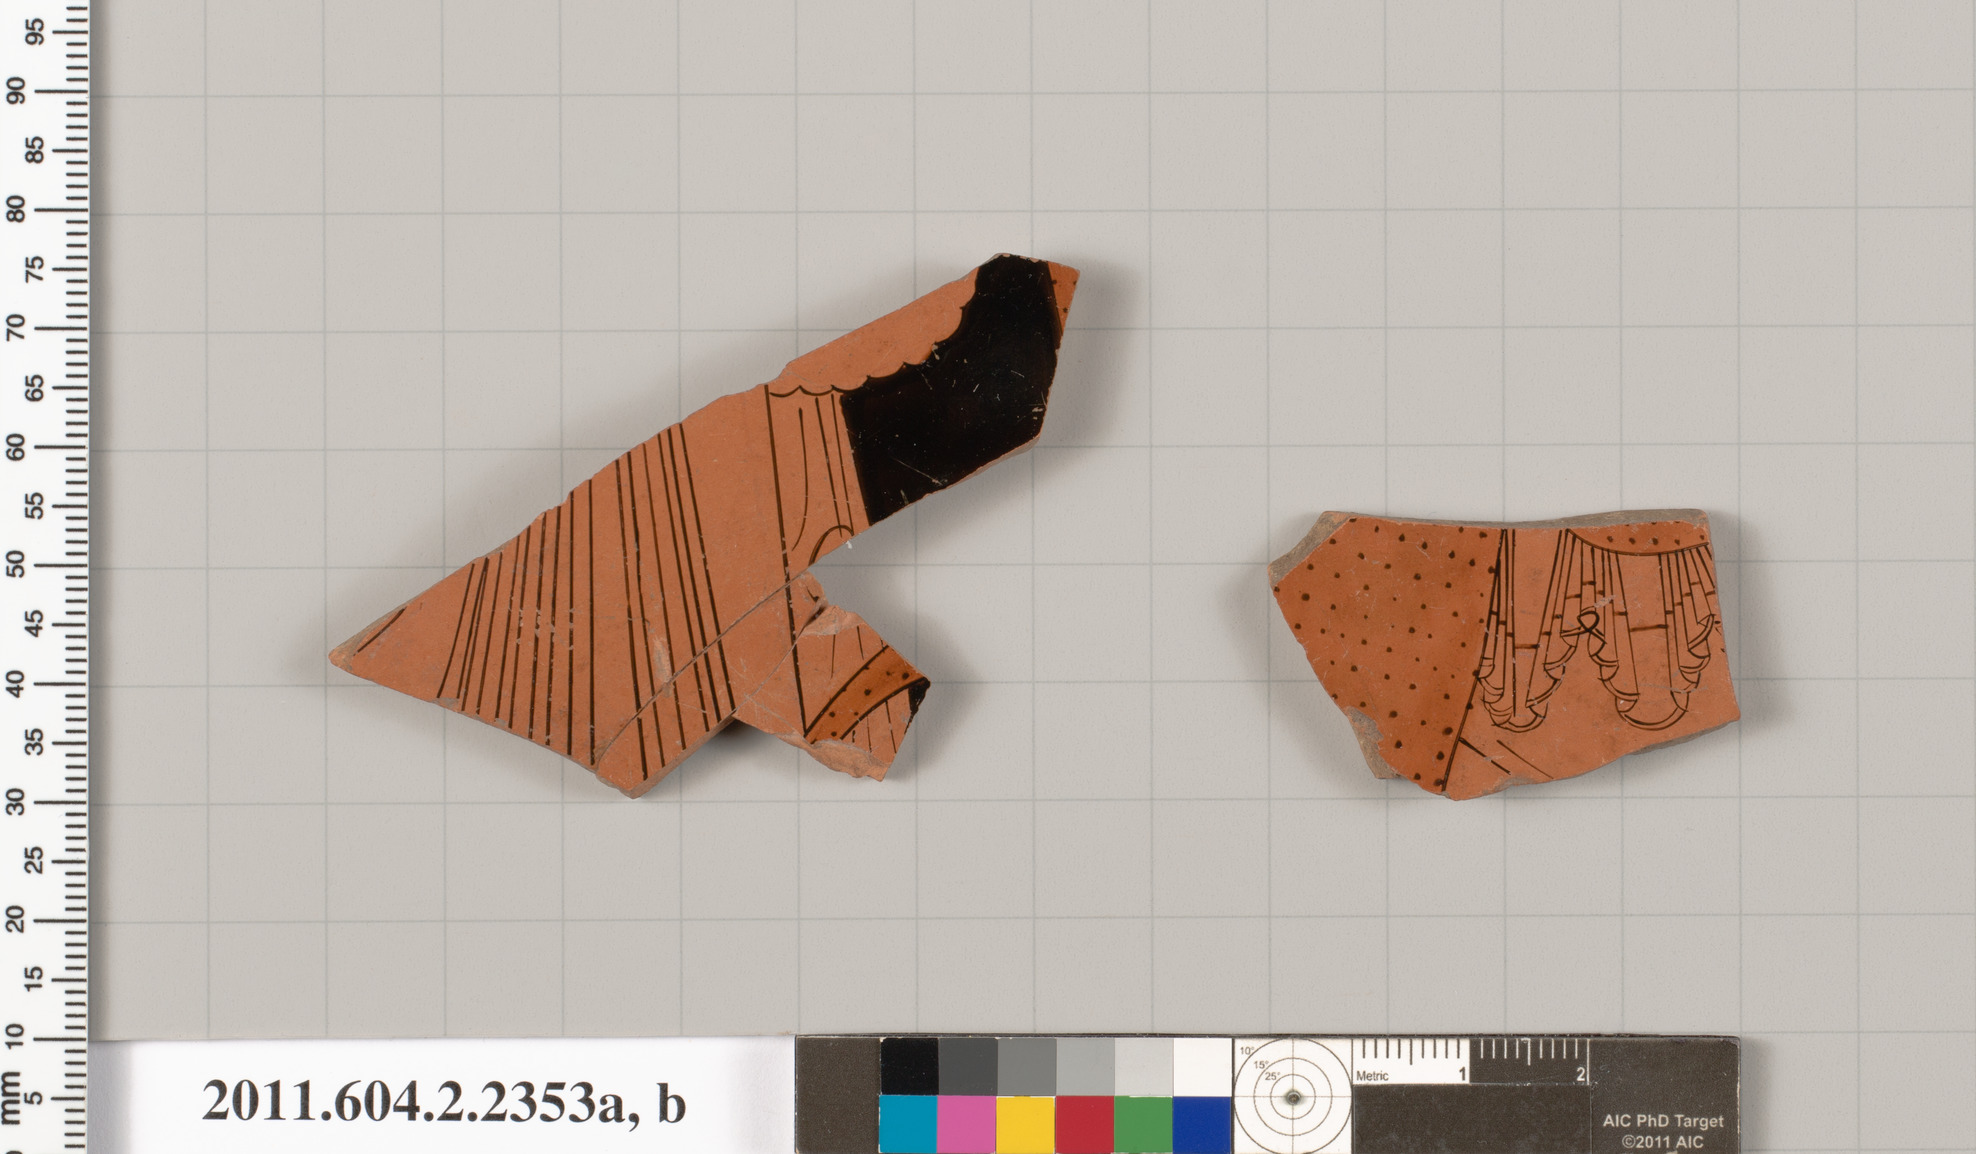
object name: pot fragment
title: Terracotta fragments of a pot; glazed on the inside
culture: greek, attic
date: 520-500 BCE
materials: terracotta